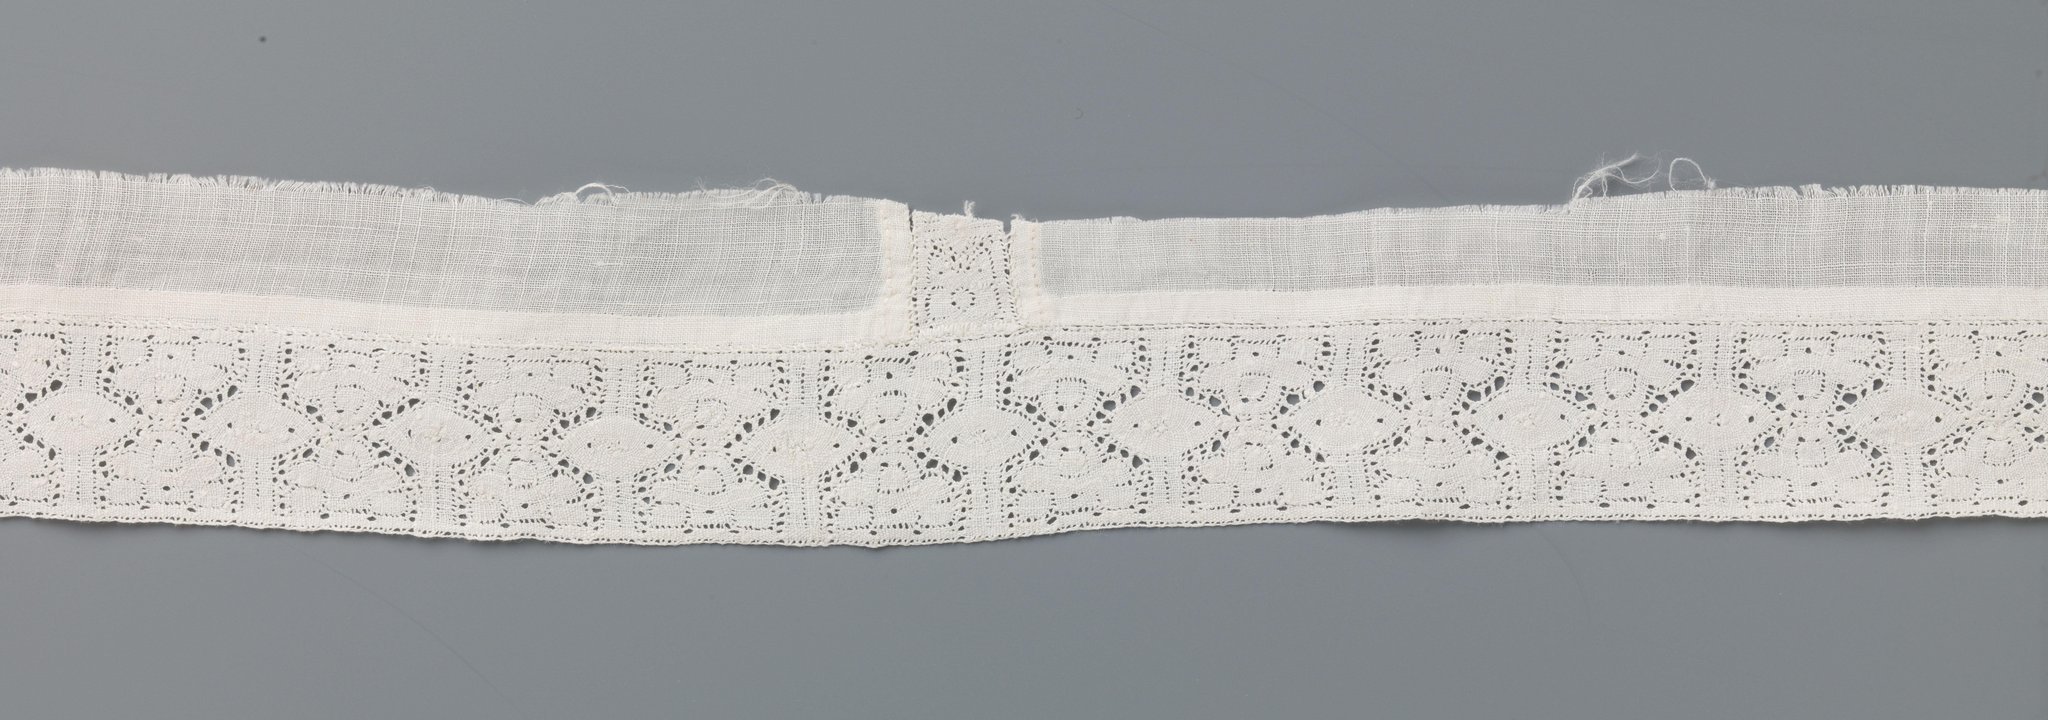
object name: strip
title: Strook kloskant met twee gestileerde gespiegelde bloemen tussen vertikale lijnen en ovalen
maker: Anonymous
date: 1600-1635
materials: linen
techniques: lace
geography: southern netherlands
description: Strook naturelkleurige Hollandse kloskant. Het patroon bestaat uit een zich herhalend motief met twee vertikale rechte lijnen, die in het midden worden oversneden door een spitsovaal. Tussen de vertikale lijnen staan twee gestileerde bloemen, die over de lengte-as zijn gespiegeld. De motieven zijn gemaakt in dicht opeengewerkte linnenslag met uitsparingen. Er is nauwelijks sprake van een grond, de motieven worden door zeer korte vlechtjes bij elkaar gehouden. Boven- en onderzijde van de strook zijn recht afgewerkt. Langs één lange zijde is een smalle strook linnen batist te zien, mogelijk een fragment van een laken of iets dergelijks, waaraan de strook oorspronkelijk was bevestigd.